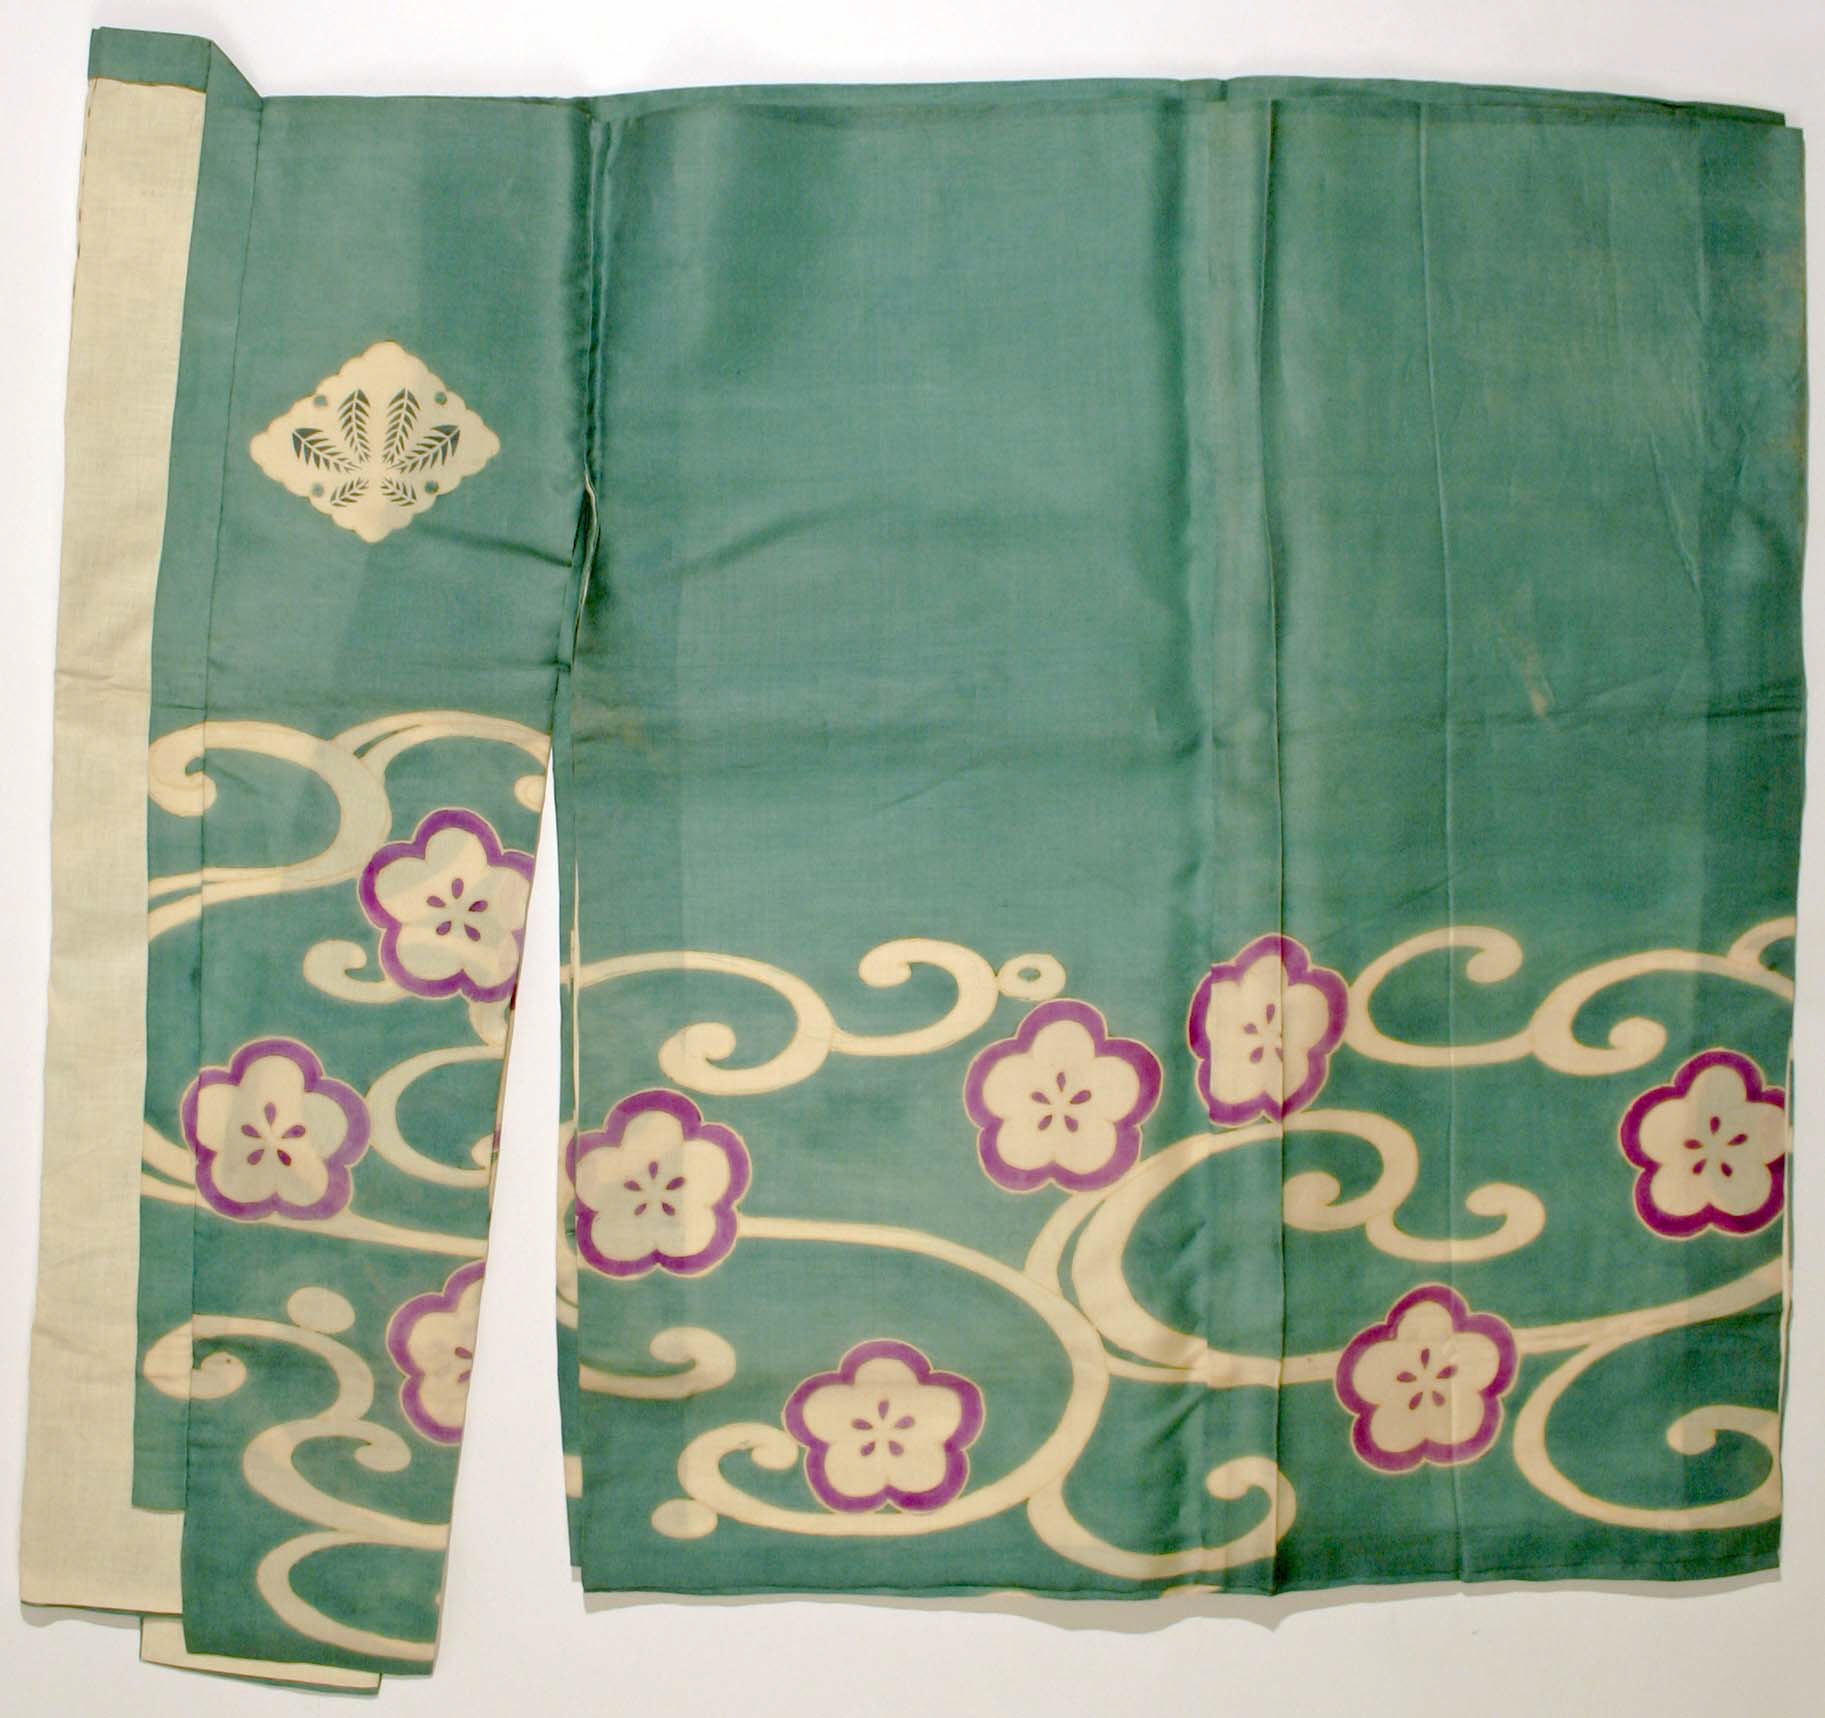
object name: theatrical costume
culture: japanese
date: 1800-1964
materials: silk